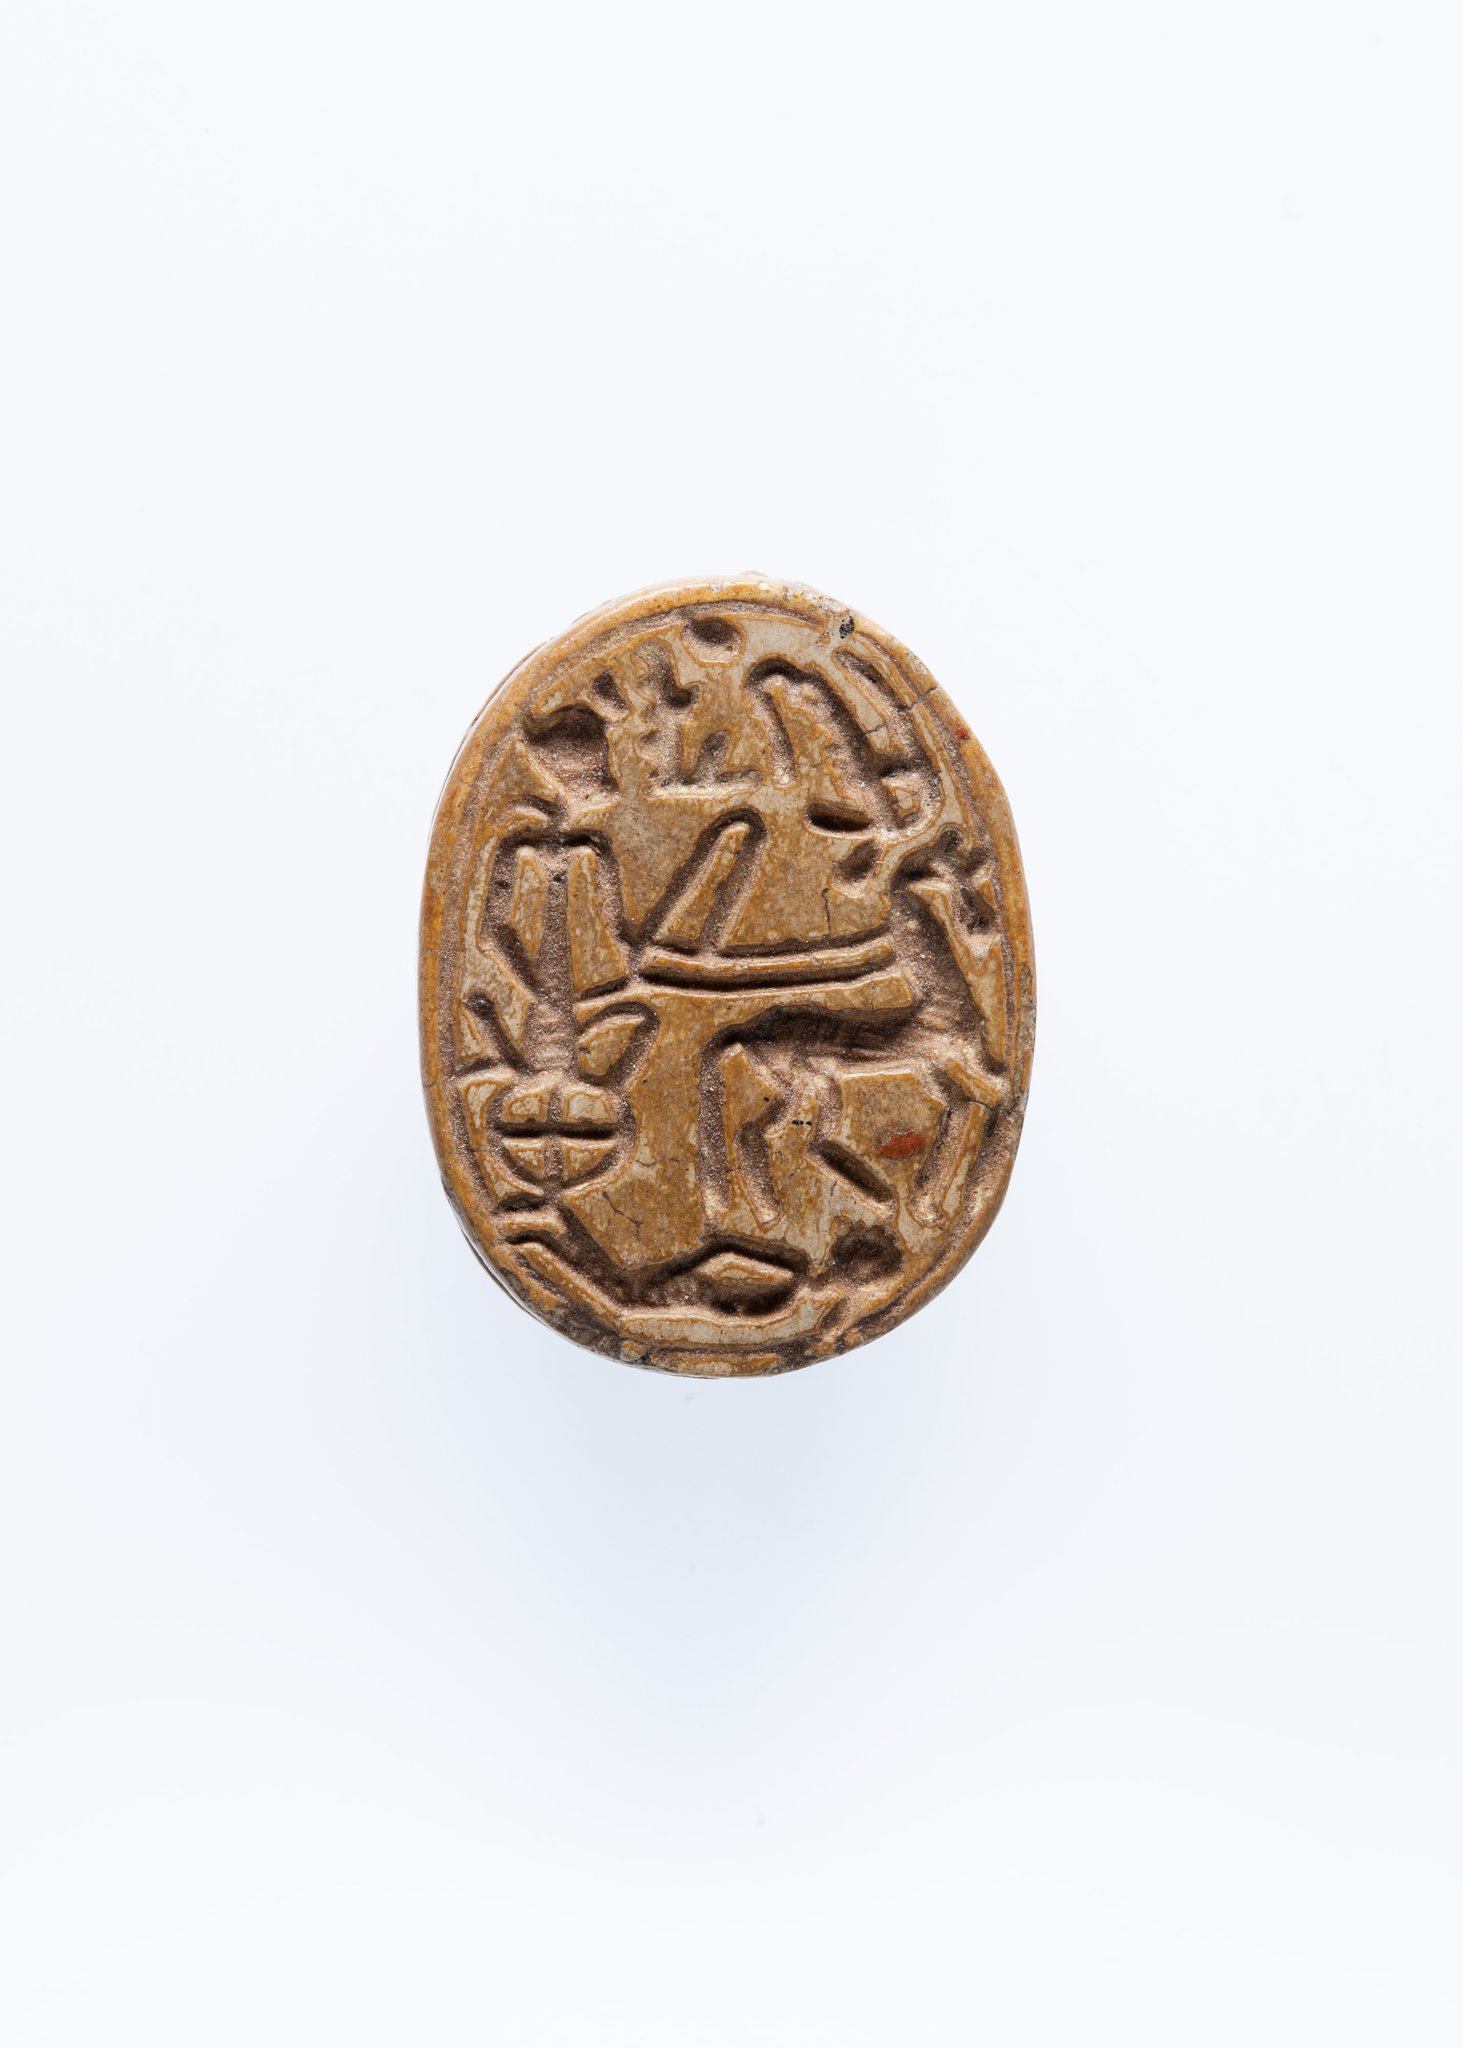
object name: scarab, charioteer, prostrate man, ramesses iv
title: Scarab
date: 1153-1147 BCE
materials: faience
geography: egypt